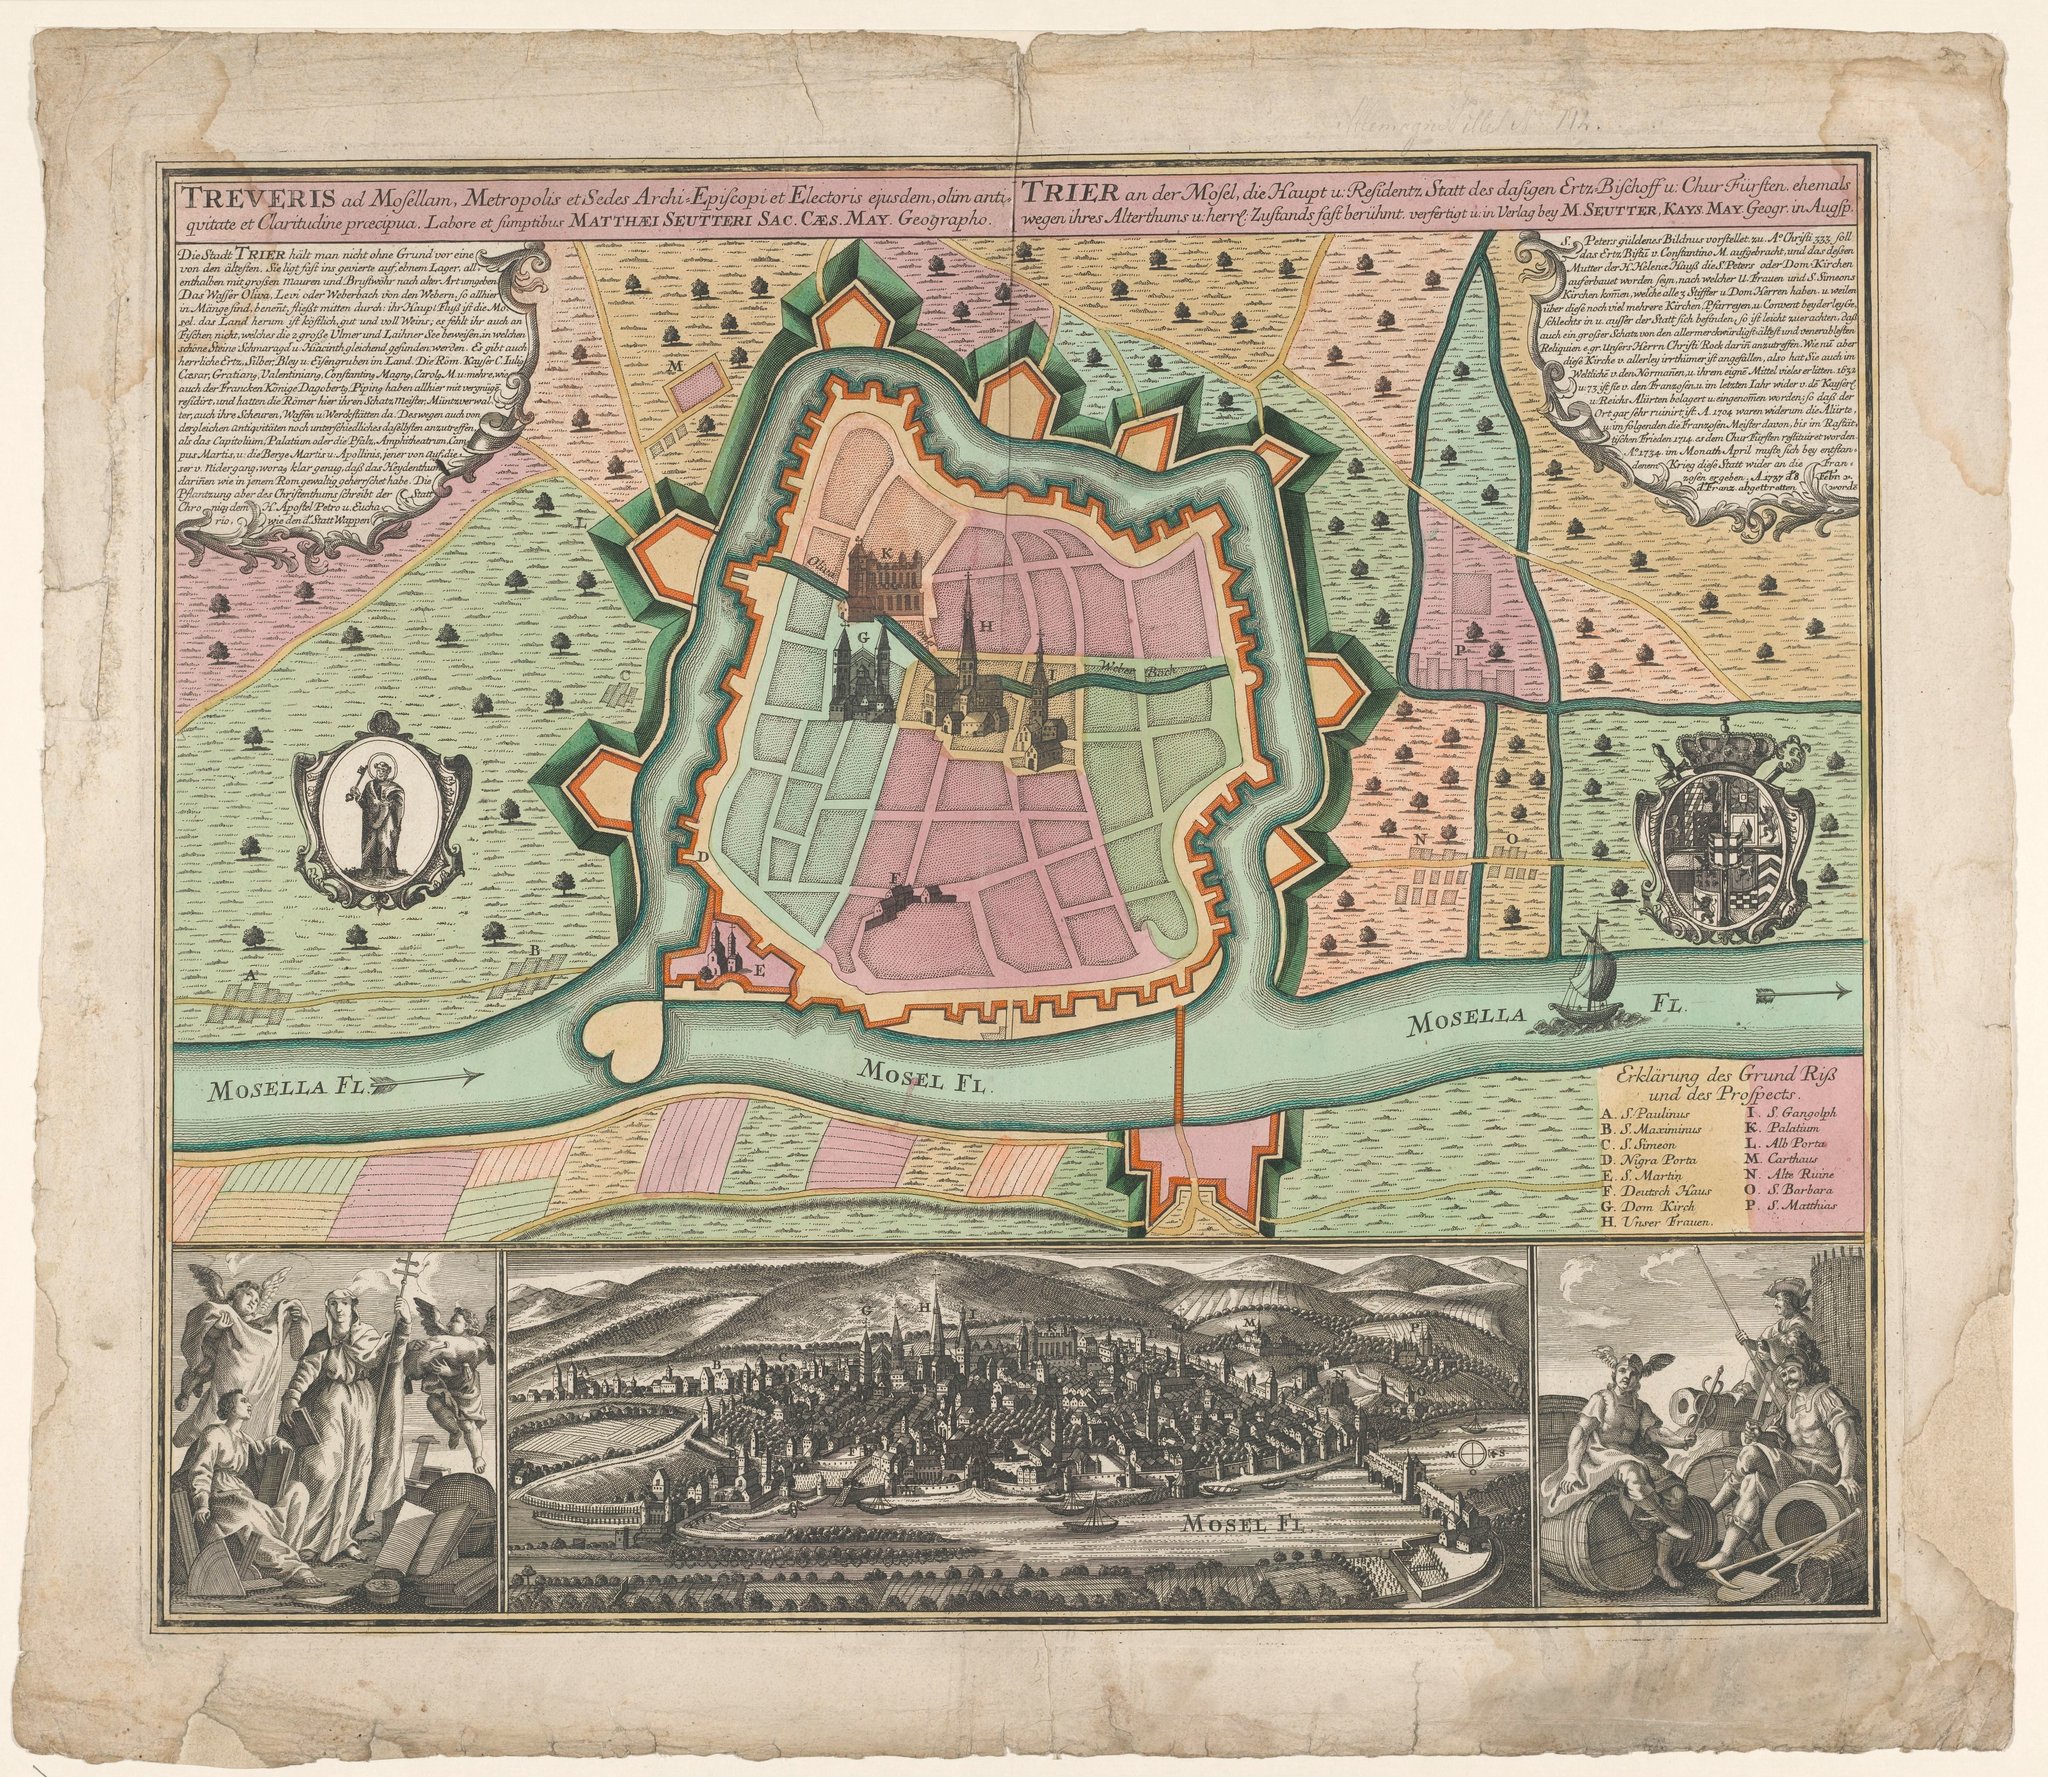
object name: area plan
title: Treveris ad Mosellam, metropolis et sedes archi: (...) / Trier an der Mosel, die haupt u: residentz statt (...)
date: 1737-1757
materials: paper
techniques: engraving, etching, hand coloring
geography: augsburg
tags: coat of arms (as symbol of the state, etc.) (+ city; municipal), relics ~ christ, (story of) mercury (hermes), maps of cities, prospect of city, town panorama, silhouette of city, armorial bearing, heraldry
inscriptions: collector's mark: Lugt 2228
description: Boven een plattegrond van Trier, met de voornaamste gebouwen in vogelvluchtperspectief. Links het wapen van de stad Trier. Onder, in het midden, een gezicht op Trier. Links daarvan een allegorische voorstelling met twee putti met relikwieën, links waarschijnlijk de Heilige Rok. Rechts een voorstelling met Mercurius en twee soldaten.